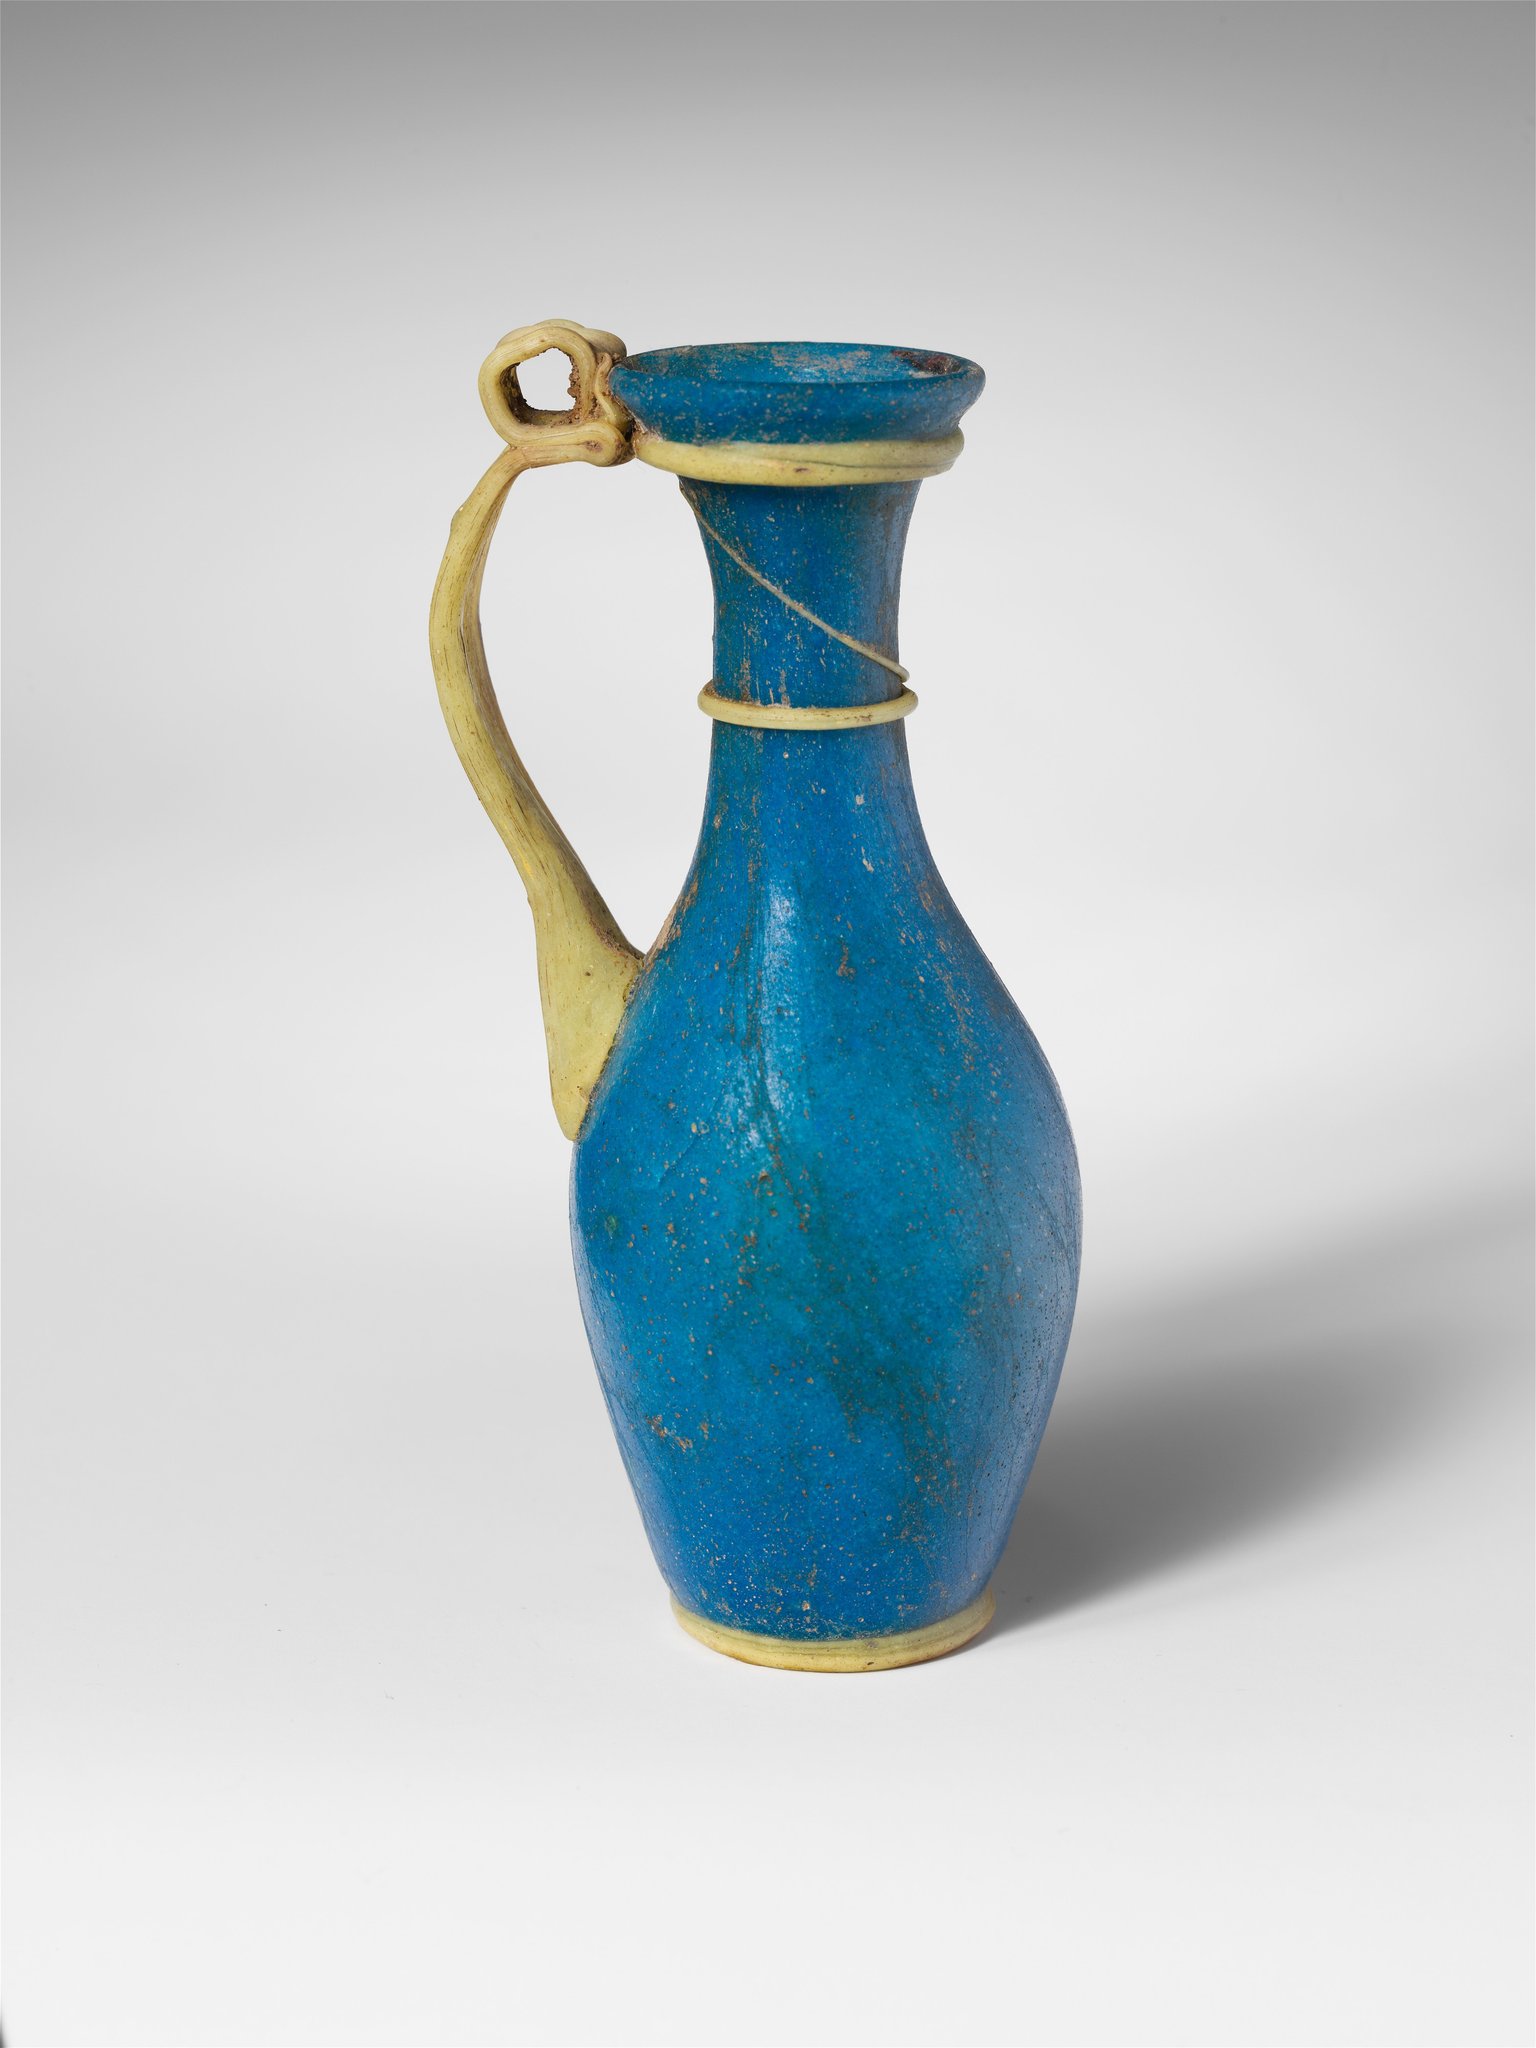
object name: jug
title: Glass jug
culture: roman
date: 201-400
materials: glass